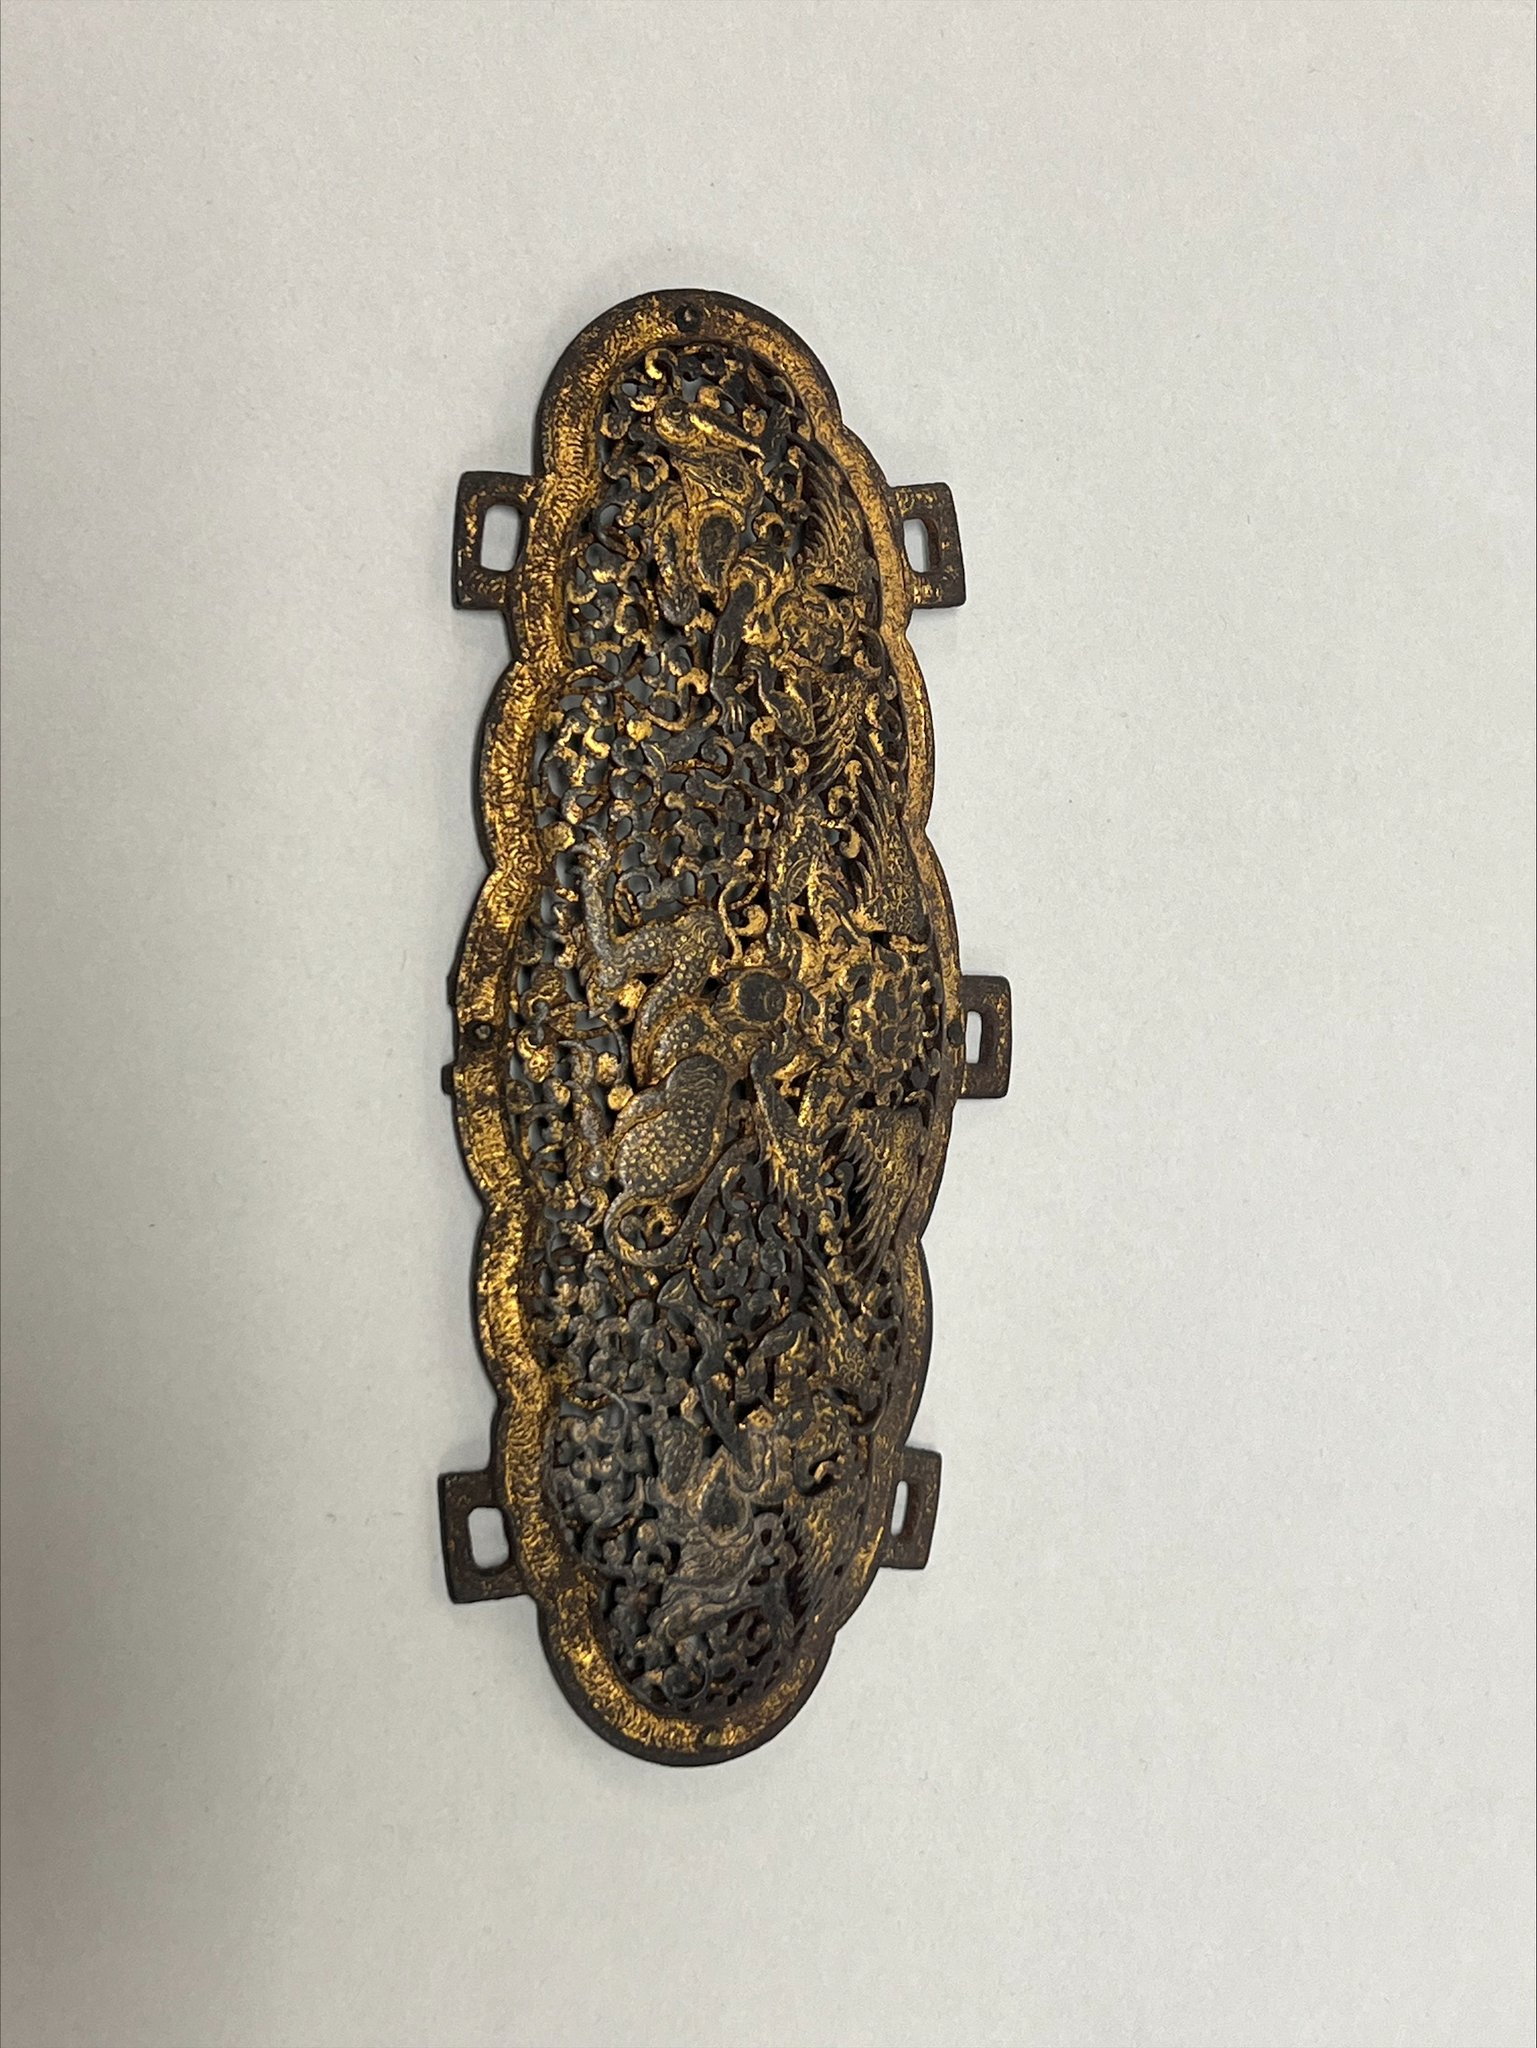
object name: horse trapping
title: Portion of a Horse Trapping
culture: tibetan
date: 1701-1800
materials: gilt bronze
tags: mythical creatures